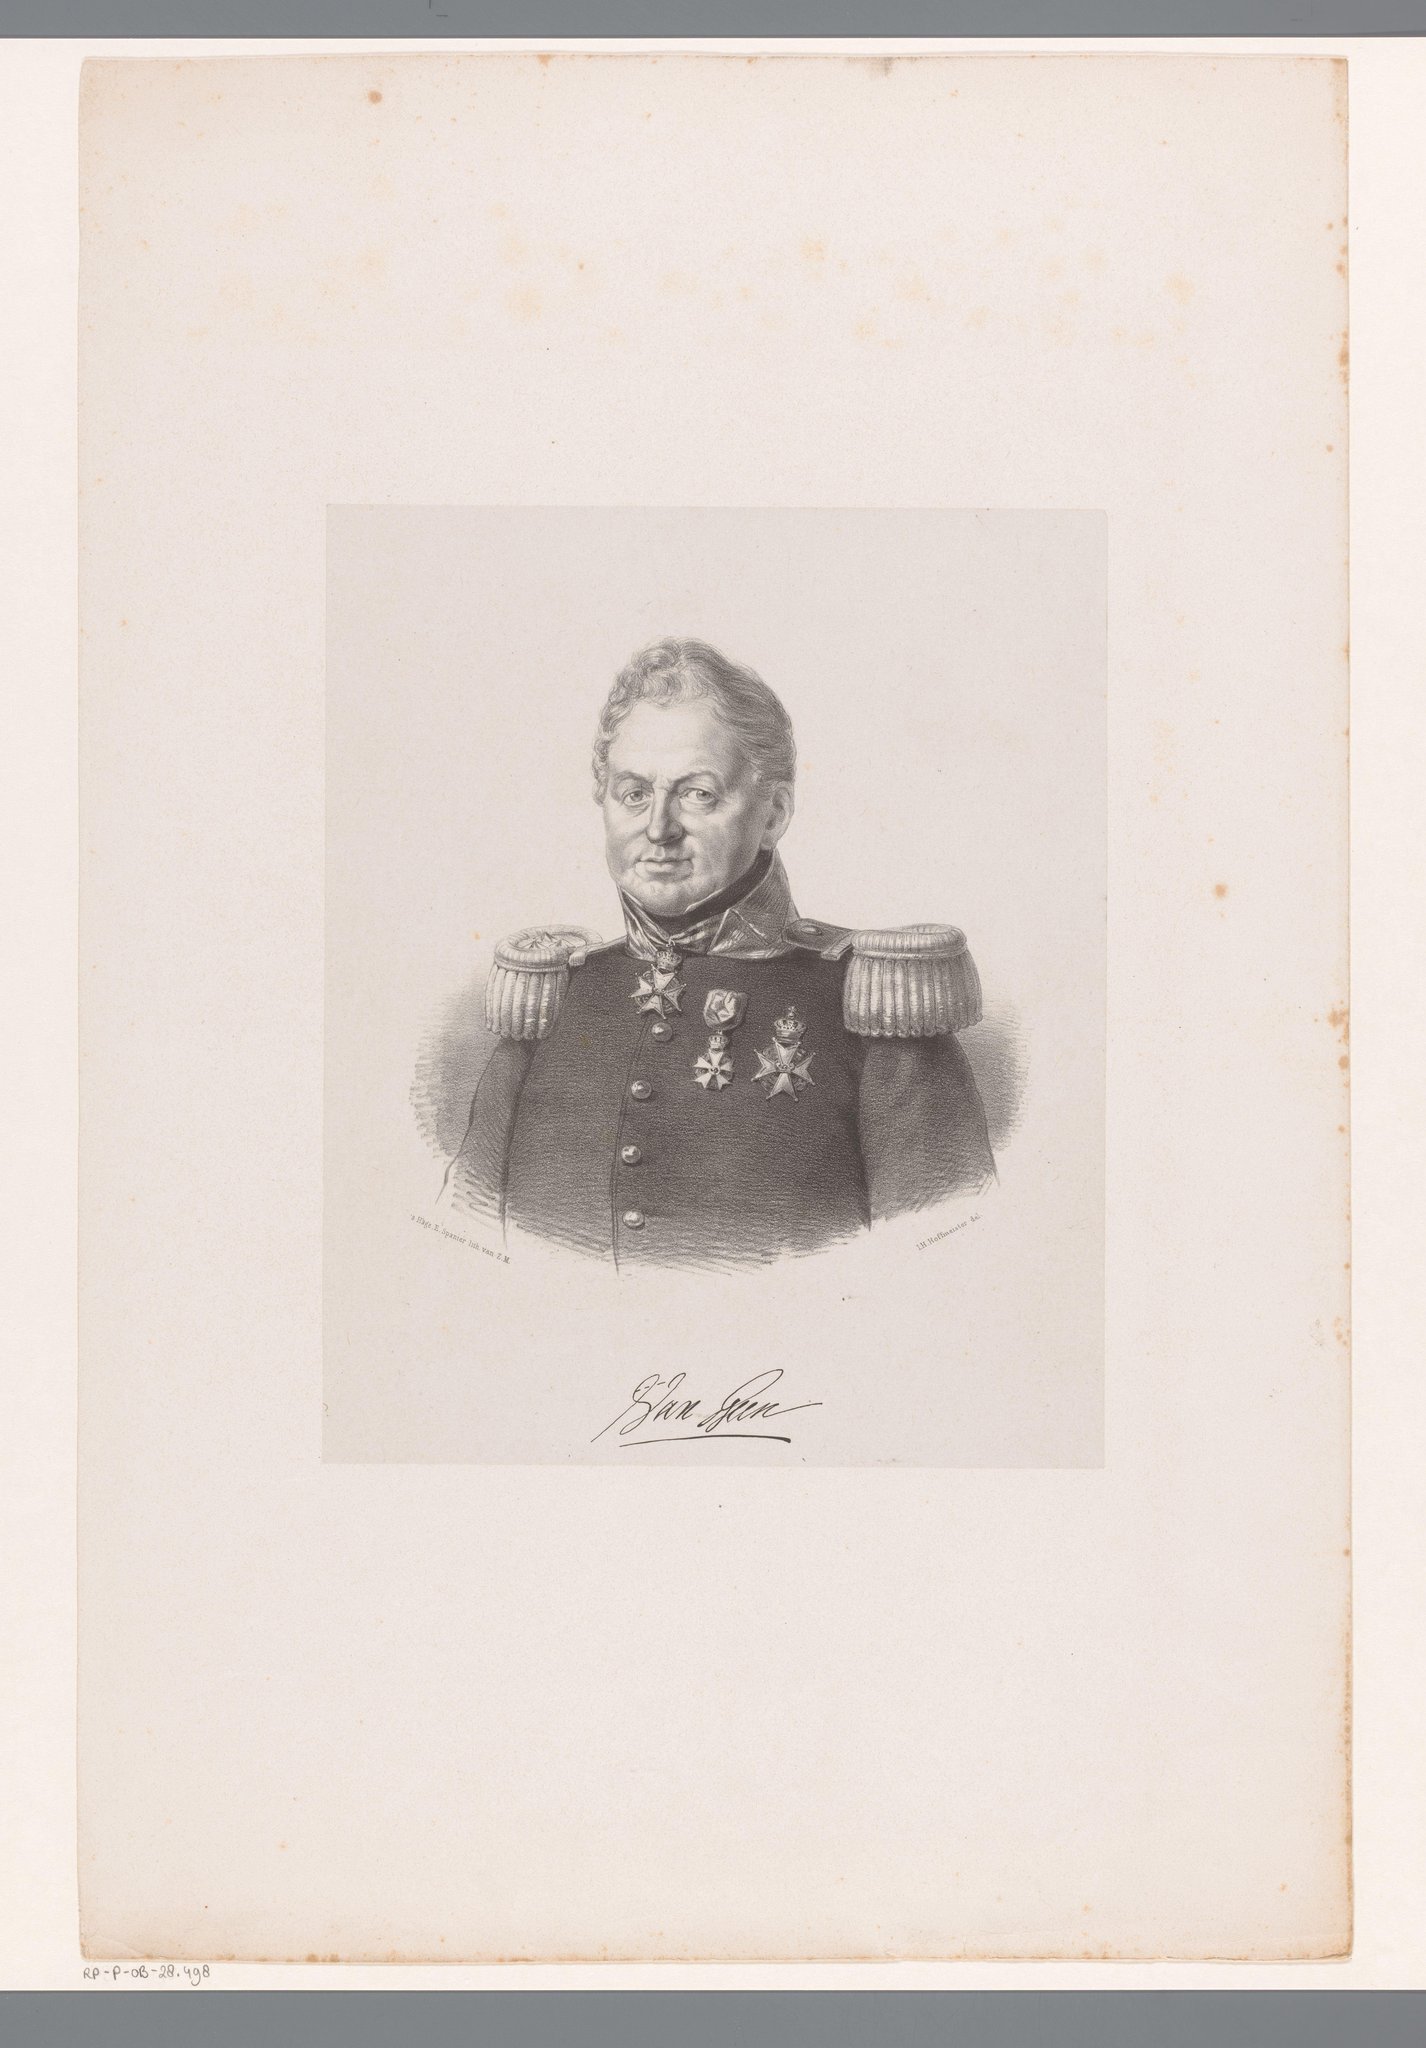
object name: print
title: Portret van Josephus Jacobus van Geen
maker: johan hendrik hoffmeister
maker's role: print maker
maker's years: 1823-1904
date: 1851-1883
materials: paper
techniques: lithograph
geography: the hague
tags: ghent, knighthood order, historical persons (+ (full) bust portrait)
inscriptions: collector's mark: Lugt 2228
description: De geportretteerde draagt een militair uniform met epauletten en drie ridderorden. Onder het portret zijn signatuur.